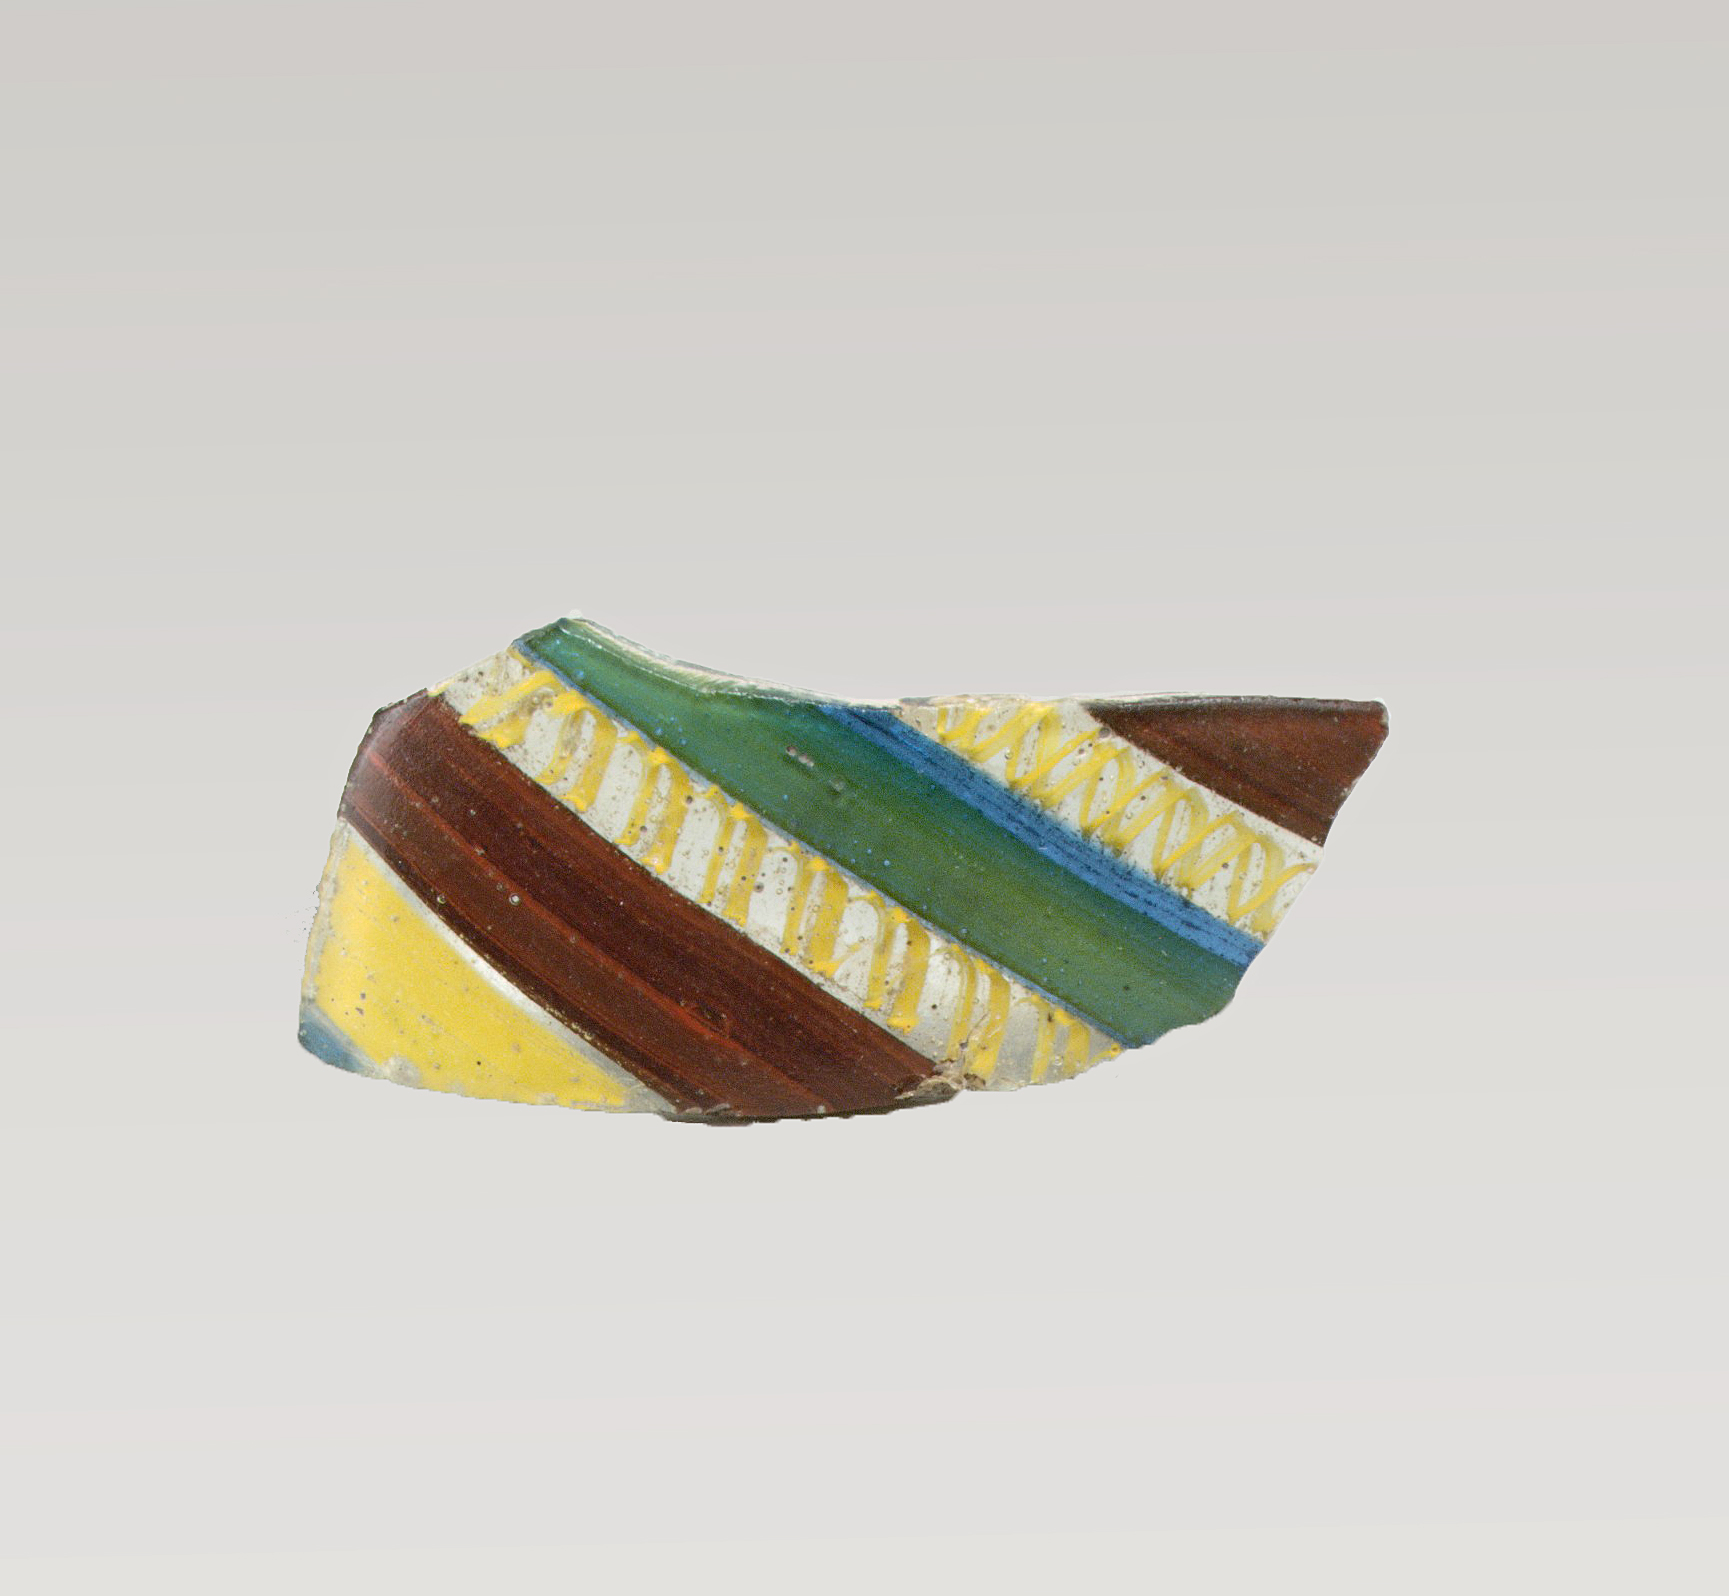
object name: fragment, striped mosaic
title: Glass striped mosaic fragment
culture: roman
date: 34 BCE-33 CE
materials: glass